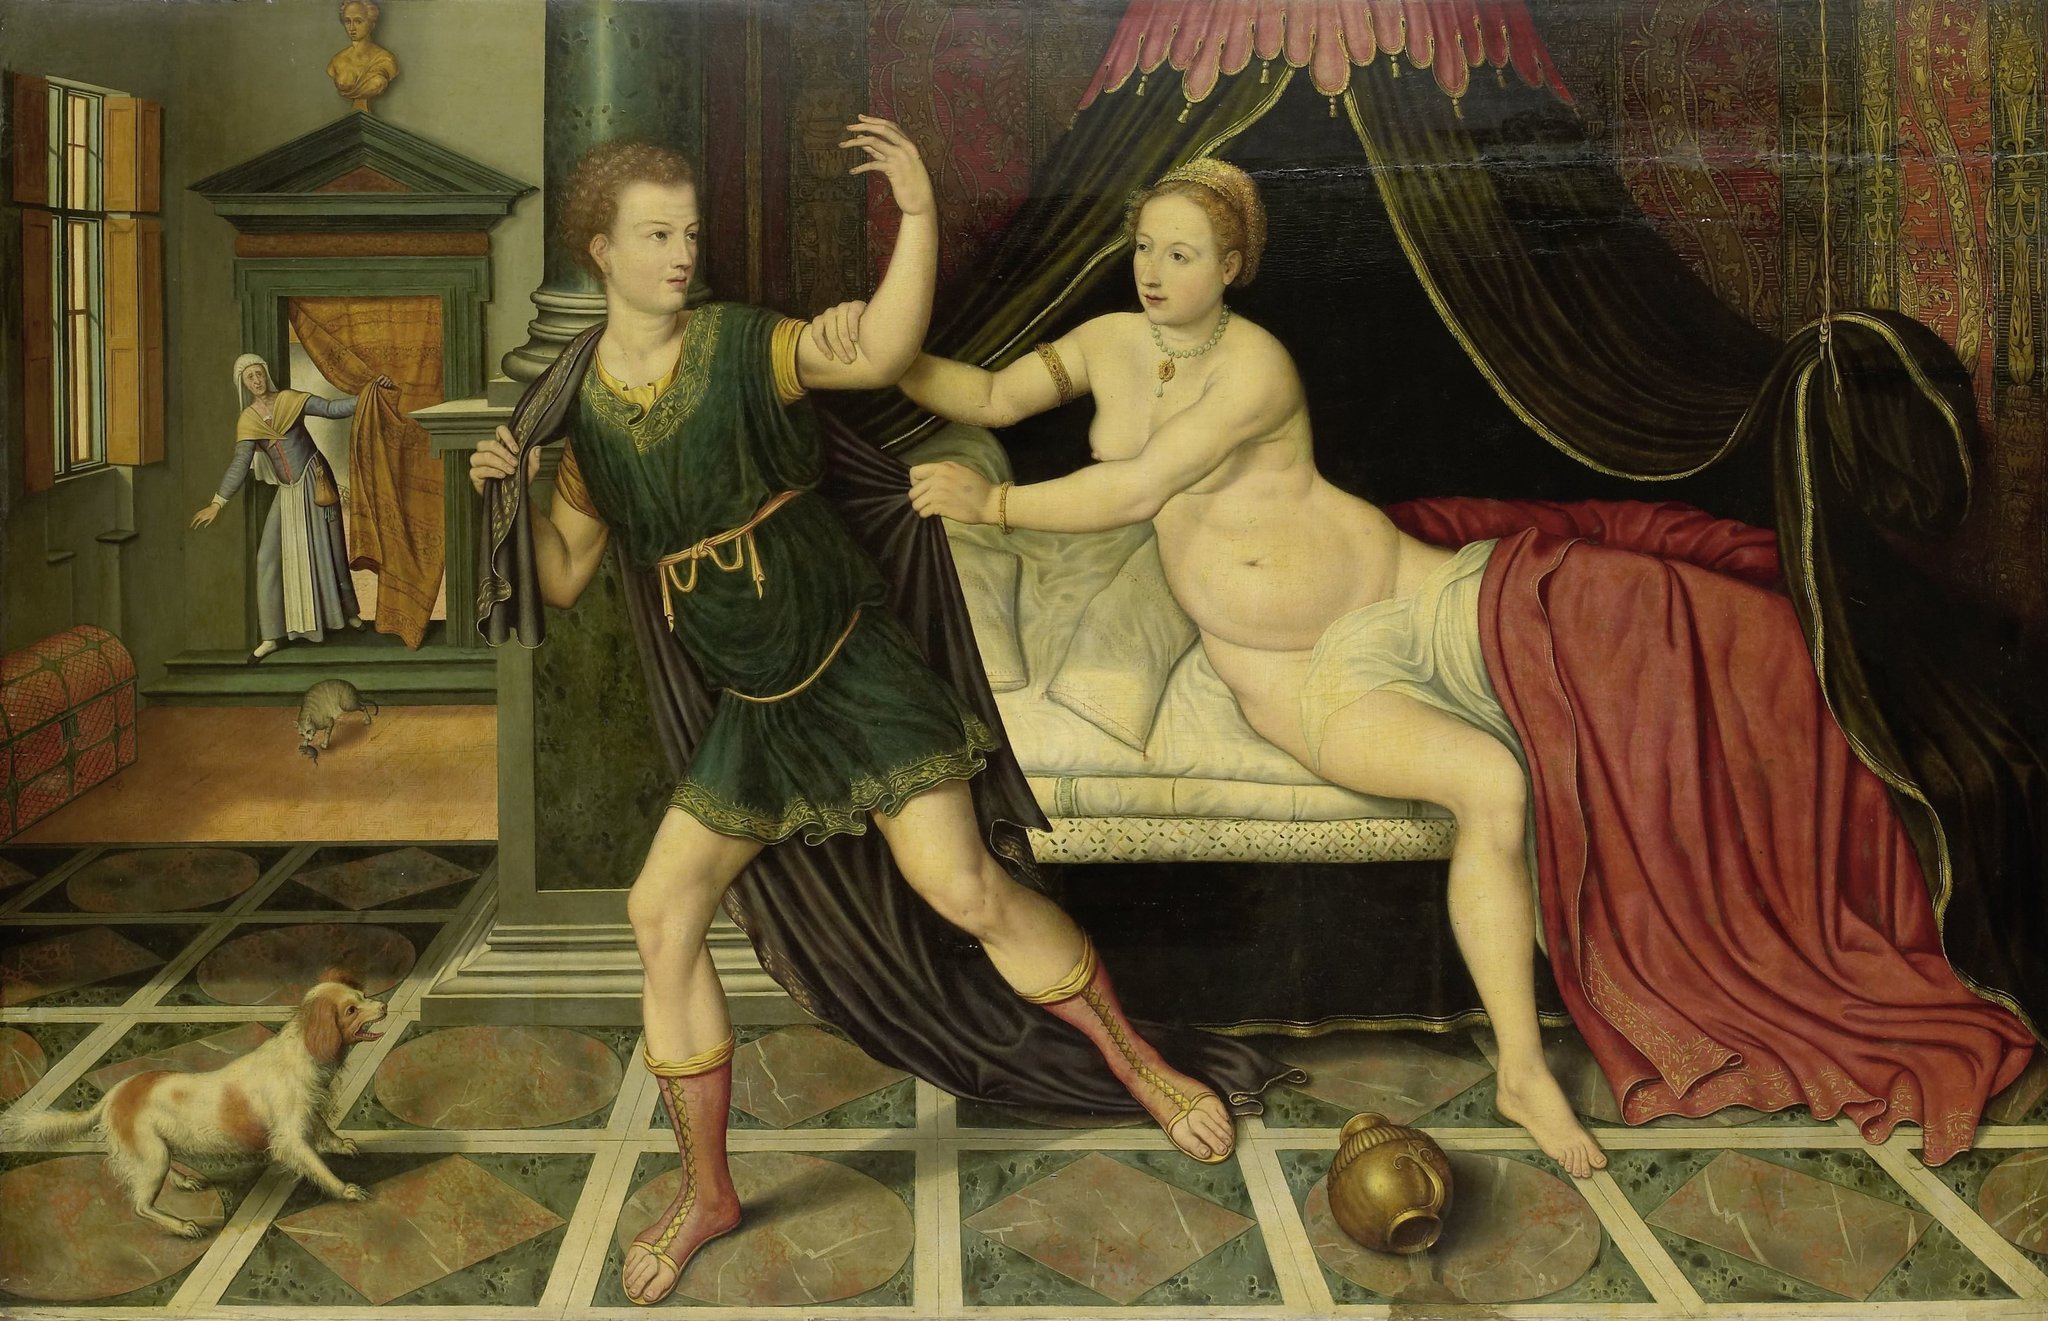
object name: painting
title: Joseph and Potiphar's Wife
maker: Anonymous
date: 1575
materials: oil, panel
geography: southern netherlands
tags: potiphar's wife catches joseph by his robe, usually while lying in bed; joseph escapes leaving his cloak behind in her hands (possibly with a naked child lying in a crib)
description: Jozef en de vrouw van Potifar. De naakte vrouw probeert Jozef in haar bed te lokken. Op de grond een omgevallen kan en links een blaffende hond. Pendant van SK-A-1287. Op de achtergrond staat een dienstmaagd verschrikt bij de deur, vlak daarvoor speelt een kat met een muis.